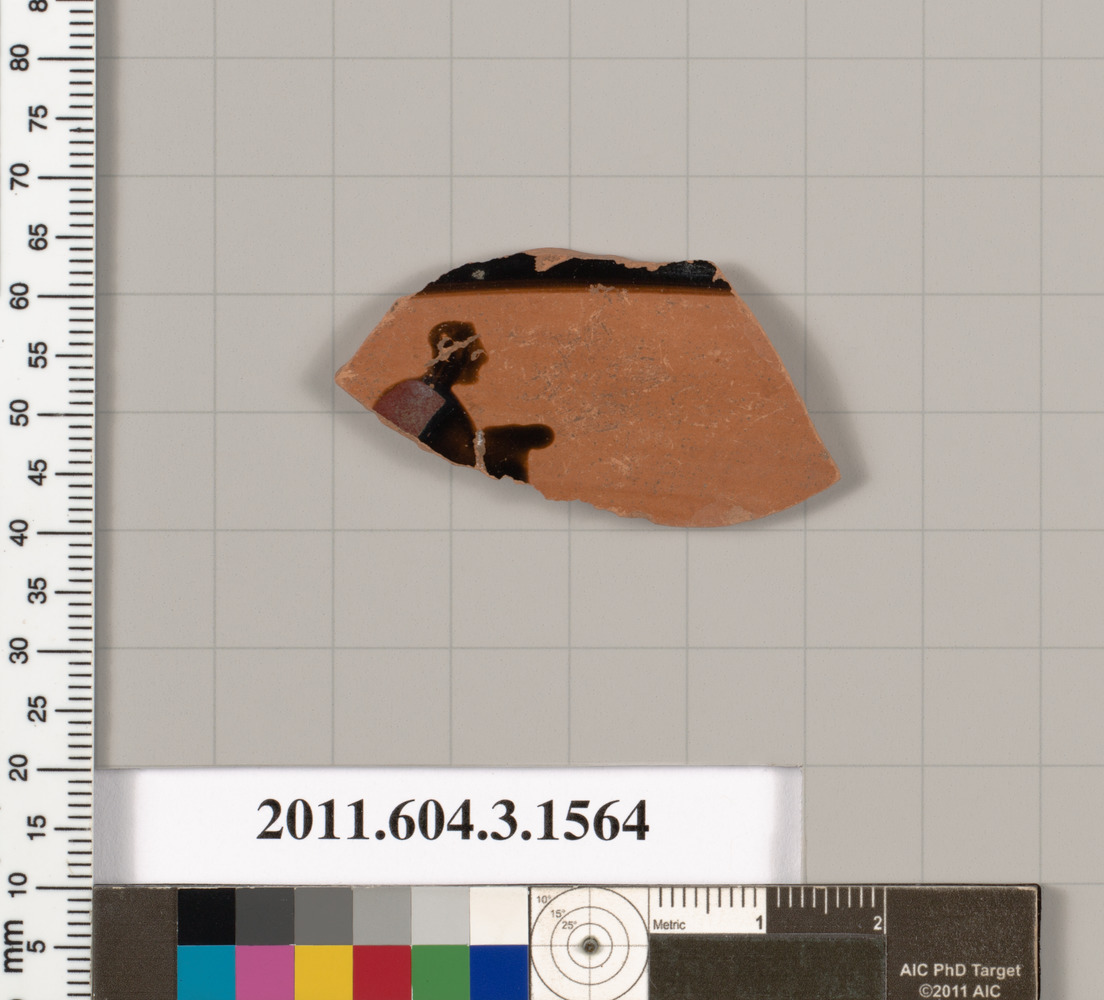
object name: kylix fragment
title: Terracotta fragment of a kylix: Band cup (drinking cup)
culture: greek, attic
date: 550-526 BCE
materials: terracotta